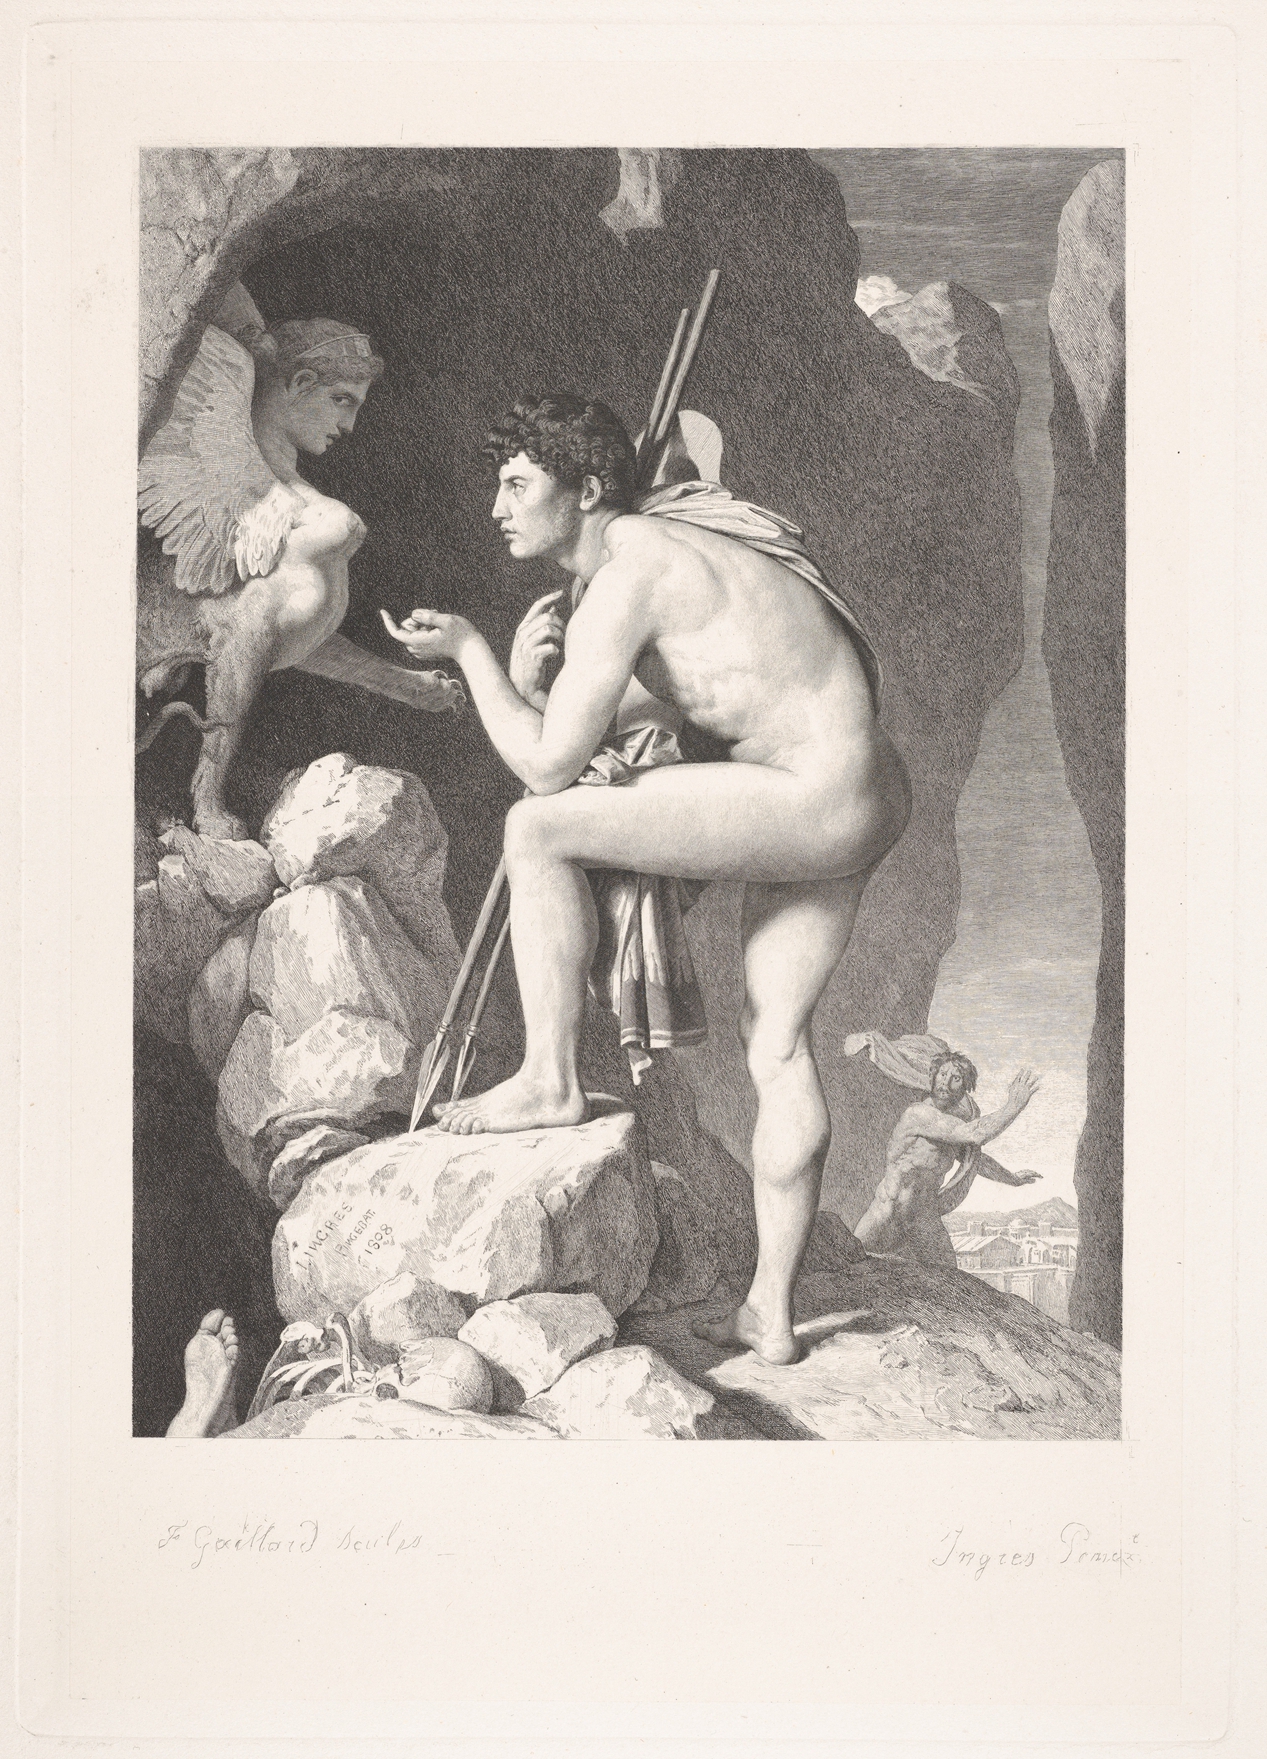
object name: print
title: Oedipus and the Sphinx, after Ingres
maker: claude-ferdinand gaillard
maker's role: artist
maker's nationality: french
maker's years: 1834-1887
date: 1867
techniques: engraving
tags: oedipus,sphinx